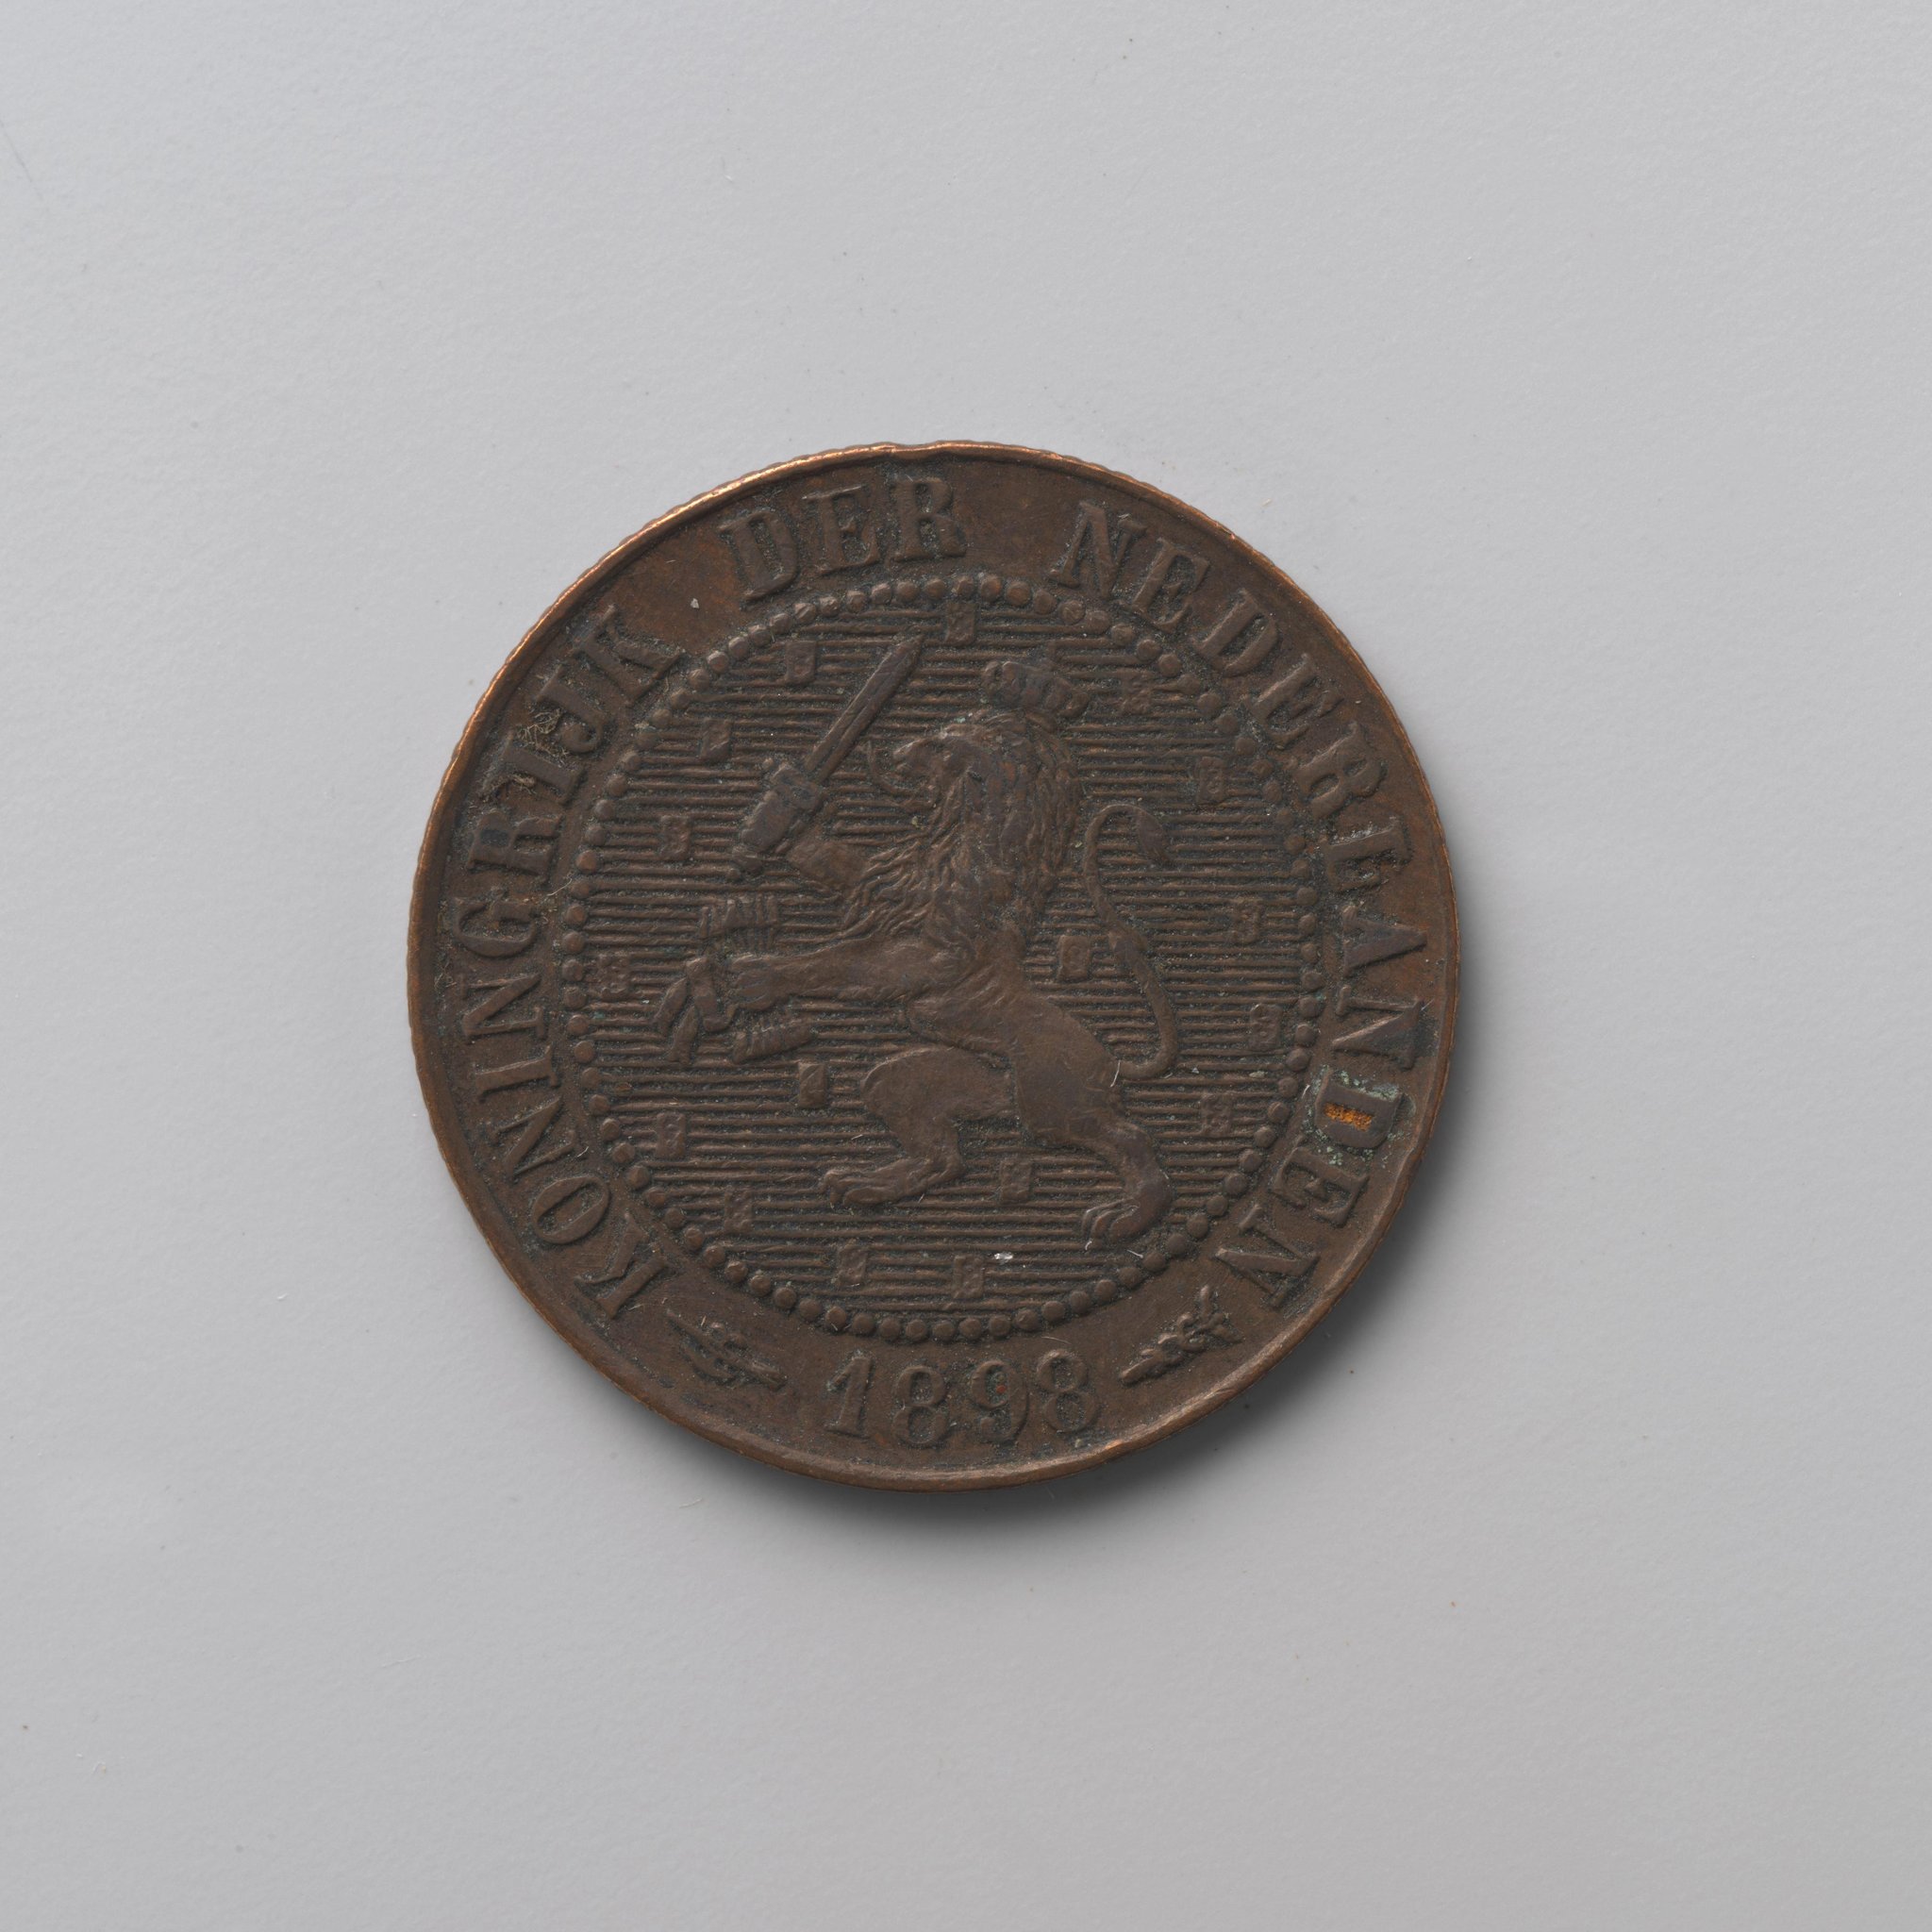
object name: twee en een halve cent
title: Nederlandse 2½ cent,1898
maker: wilhelmina of the netherlands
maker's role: print maker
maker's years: 1880-1962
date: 1898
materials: bronze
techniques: striking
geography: utrecht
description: Bronzen munt. Voorzijde: in een veld rijkswapen. Jaartal onderaan in omschrift.Keerzijde: binnen twee samengebonden oranjetakken waarde-aanduiding 2½ cent. Kartelrand.